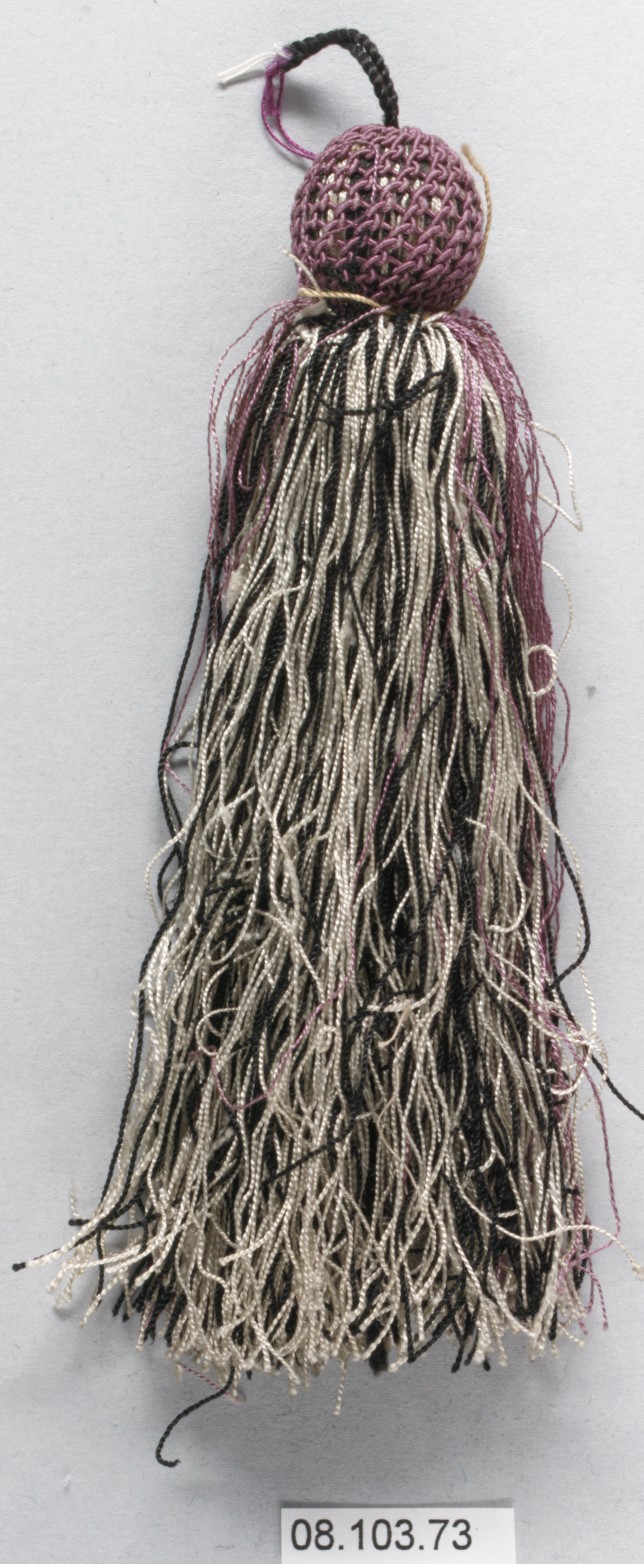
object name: tassel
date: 1801-1900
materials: silk